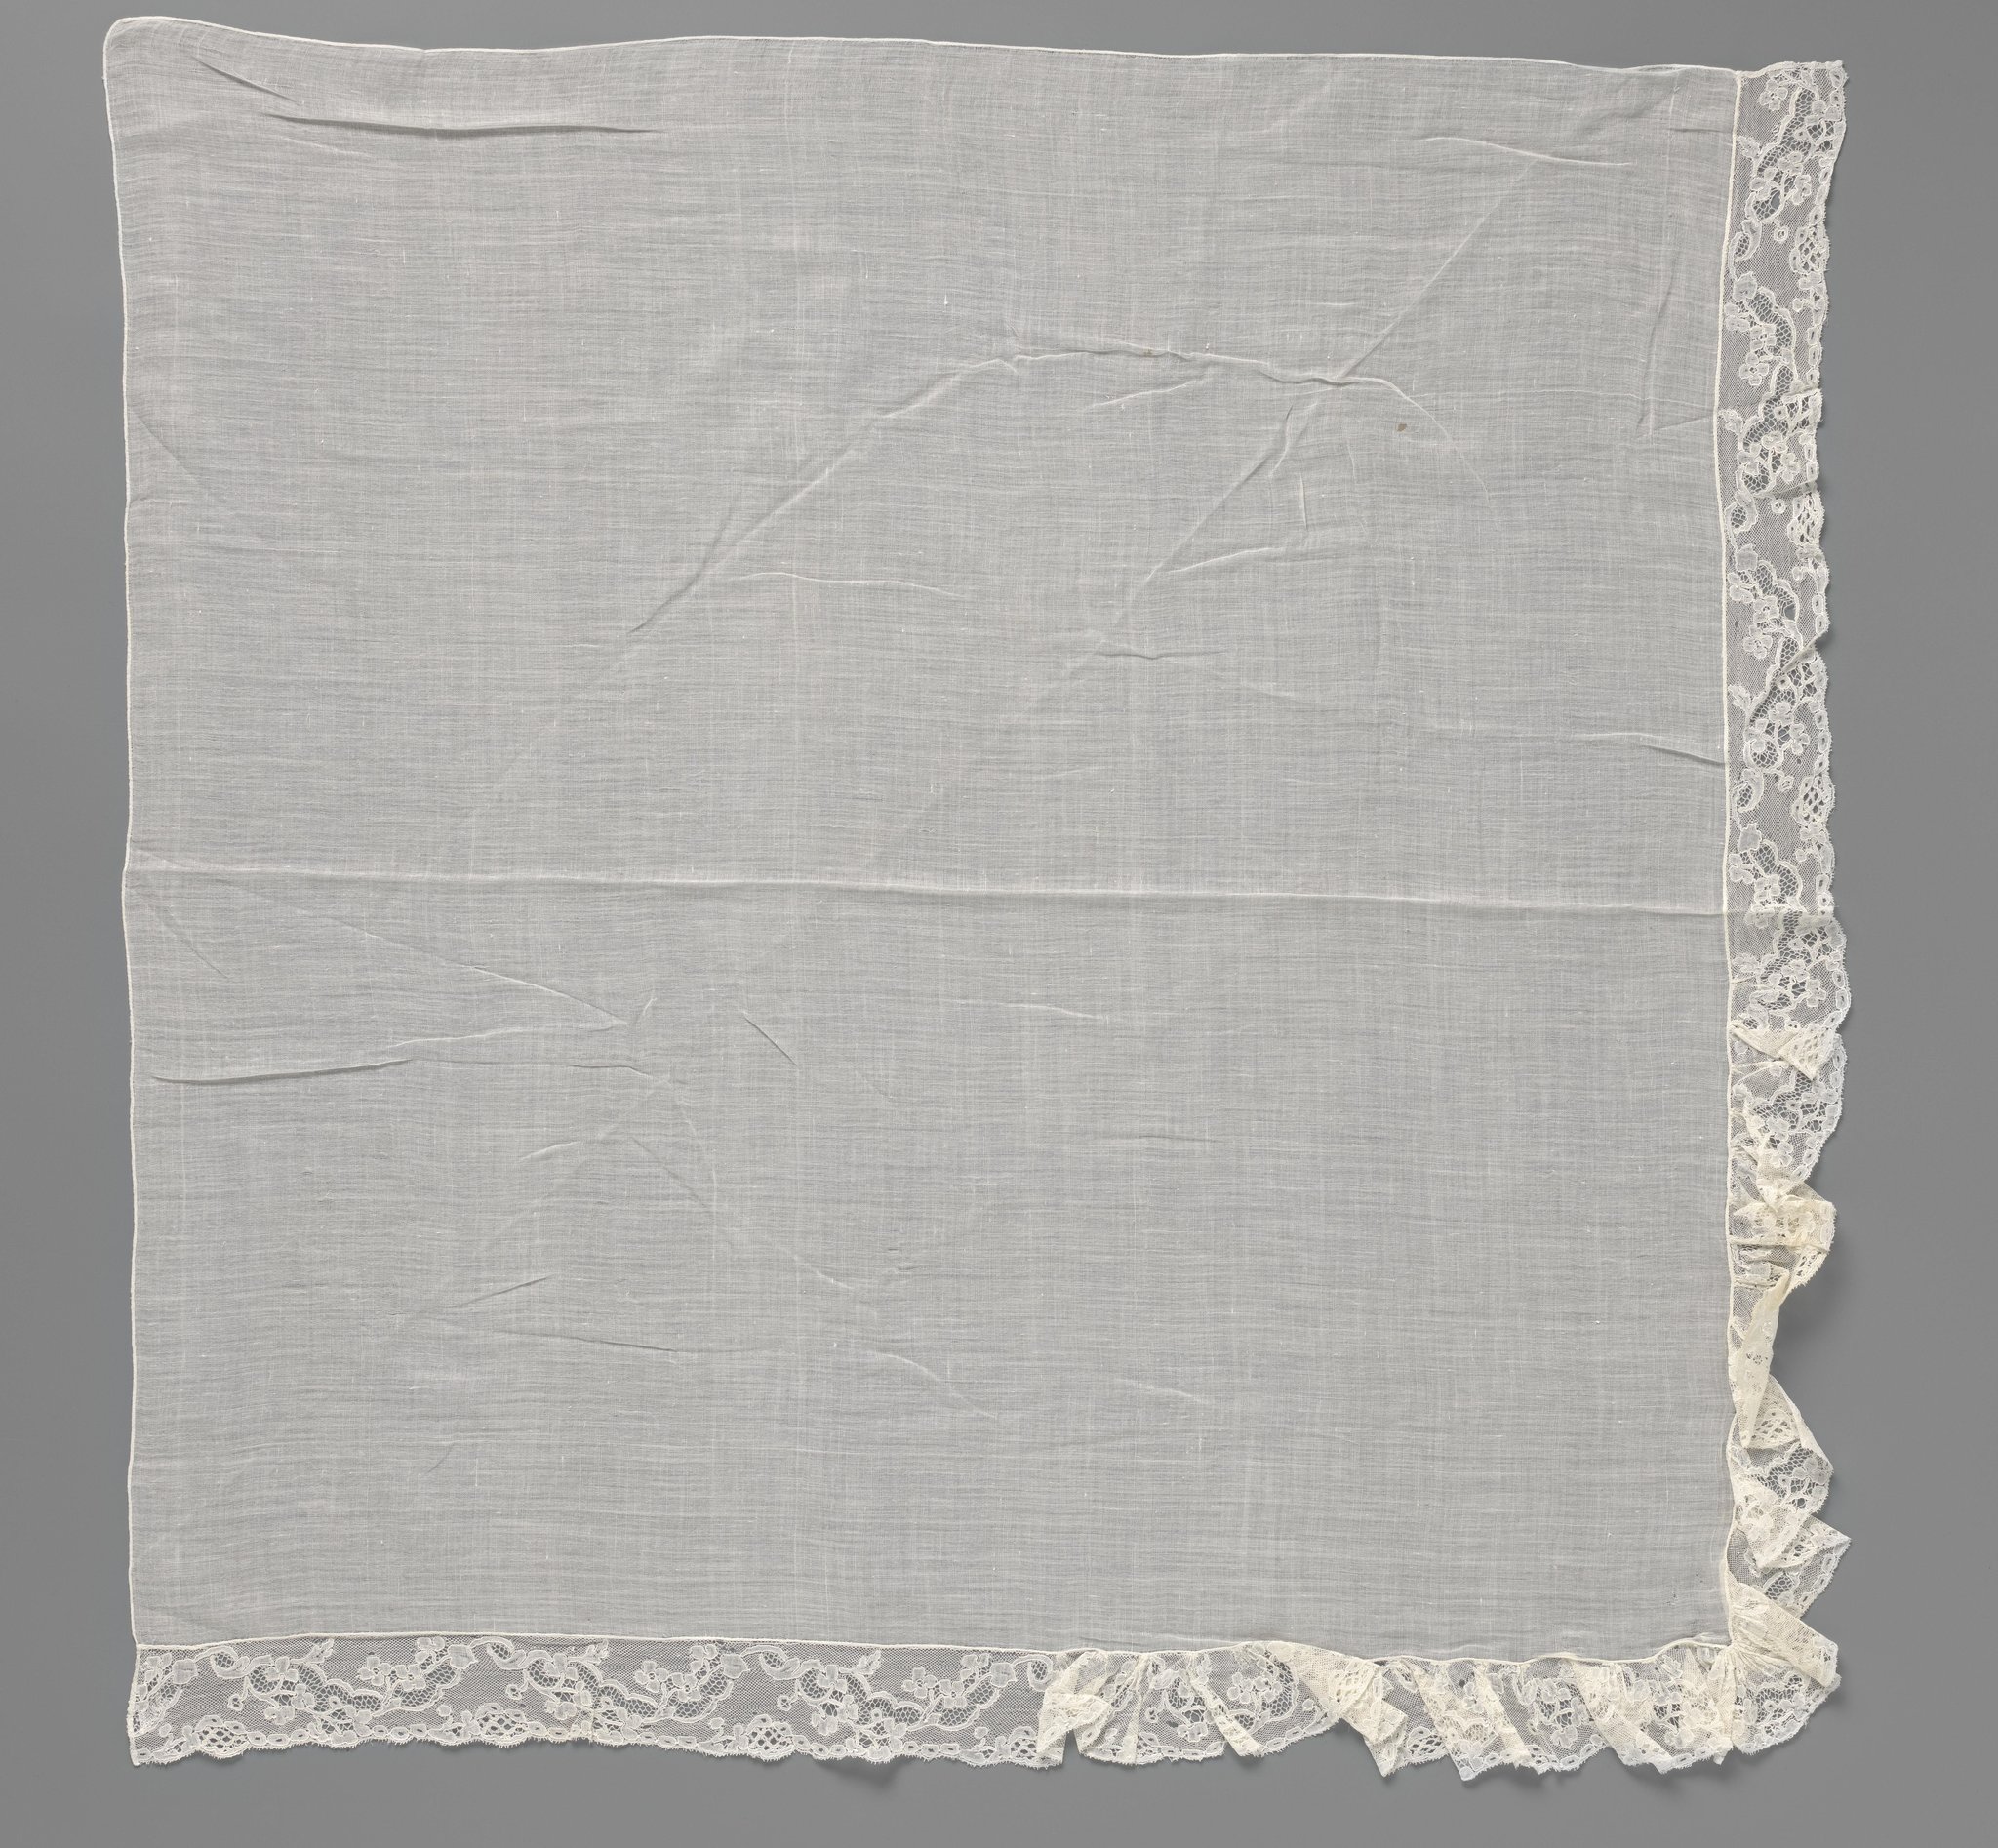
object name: fichu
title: Fichu of zogenaamde tipdoek met kloskant met opengewerkte rivierès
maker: Anonymous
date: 1770-1774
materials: textile, cotton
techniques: lace, weave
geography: mechelen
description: Fichu van naturelkleurig batist met kloskant: Mechelse kant. Vierkant model die gevouwen als een driehoek werd gedragen. Afwerking met rolzoompjes en aan twee zijden met kant die in de punt (`de tip') iets is gerimpeld. Kantpatroon: een golvende opengewerkte rank met eenvoudige bloemen en bladeren beweegt zich in een herhalend ritme voort over de lengte van de strook. Zaanse streekdracht.